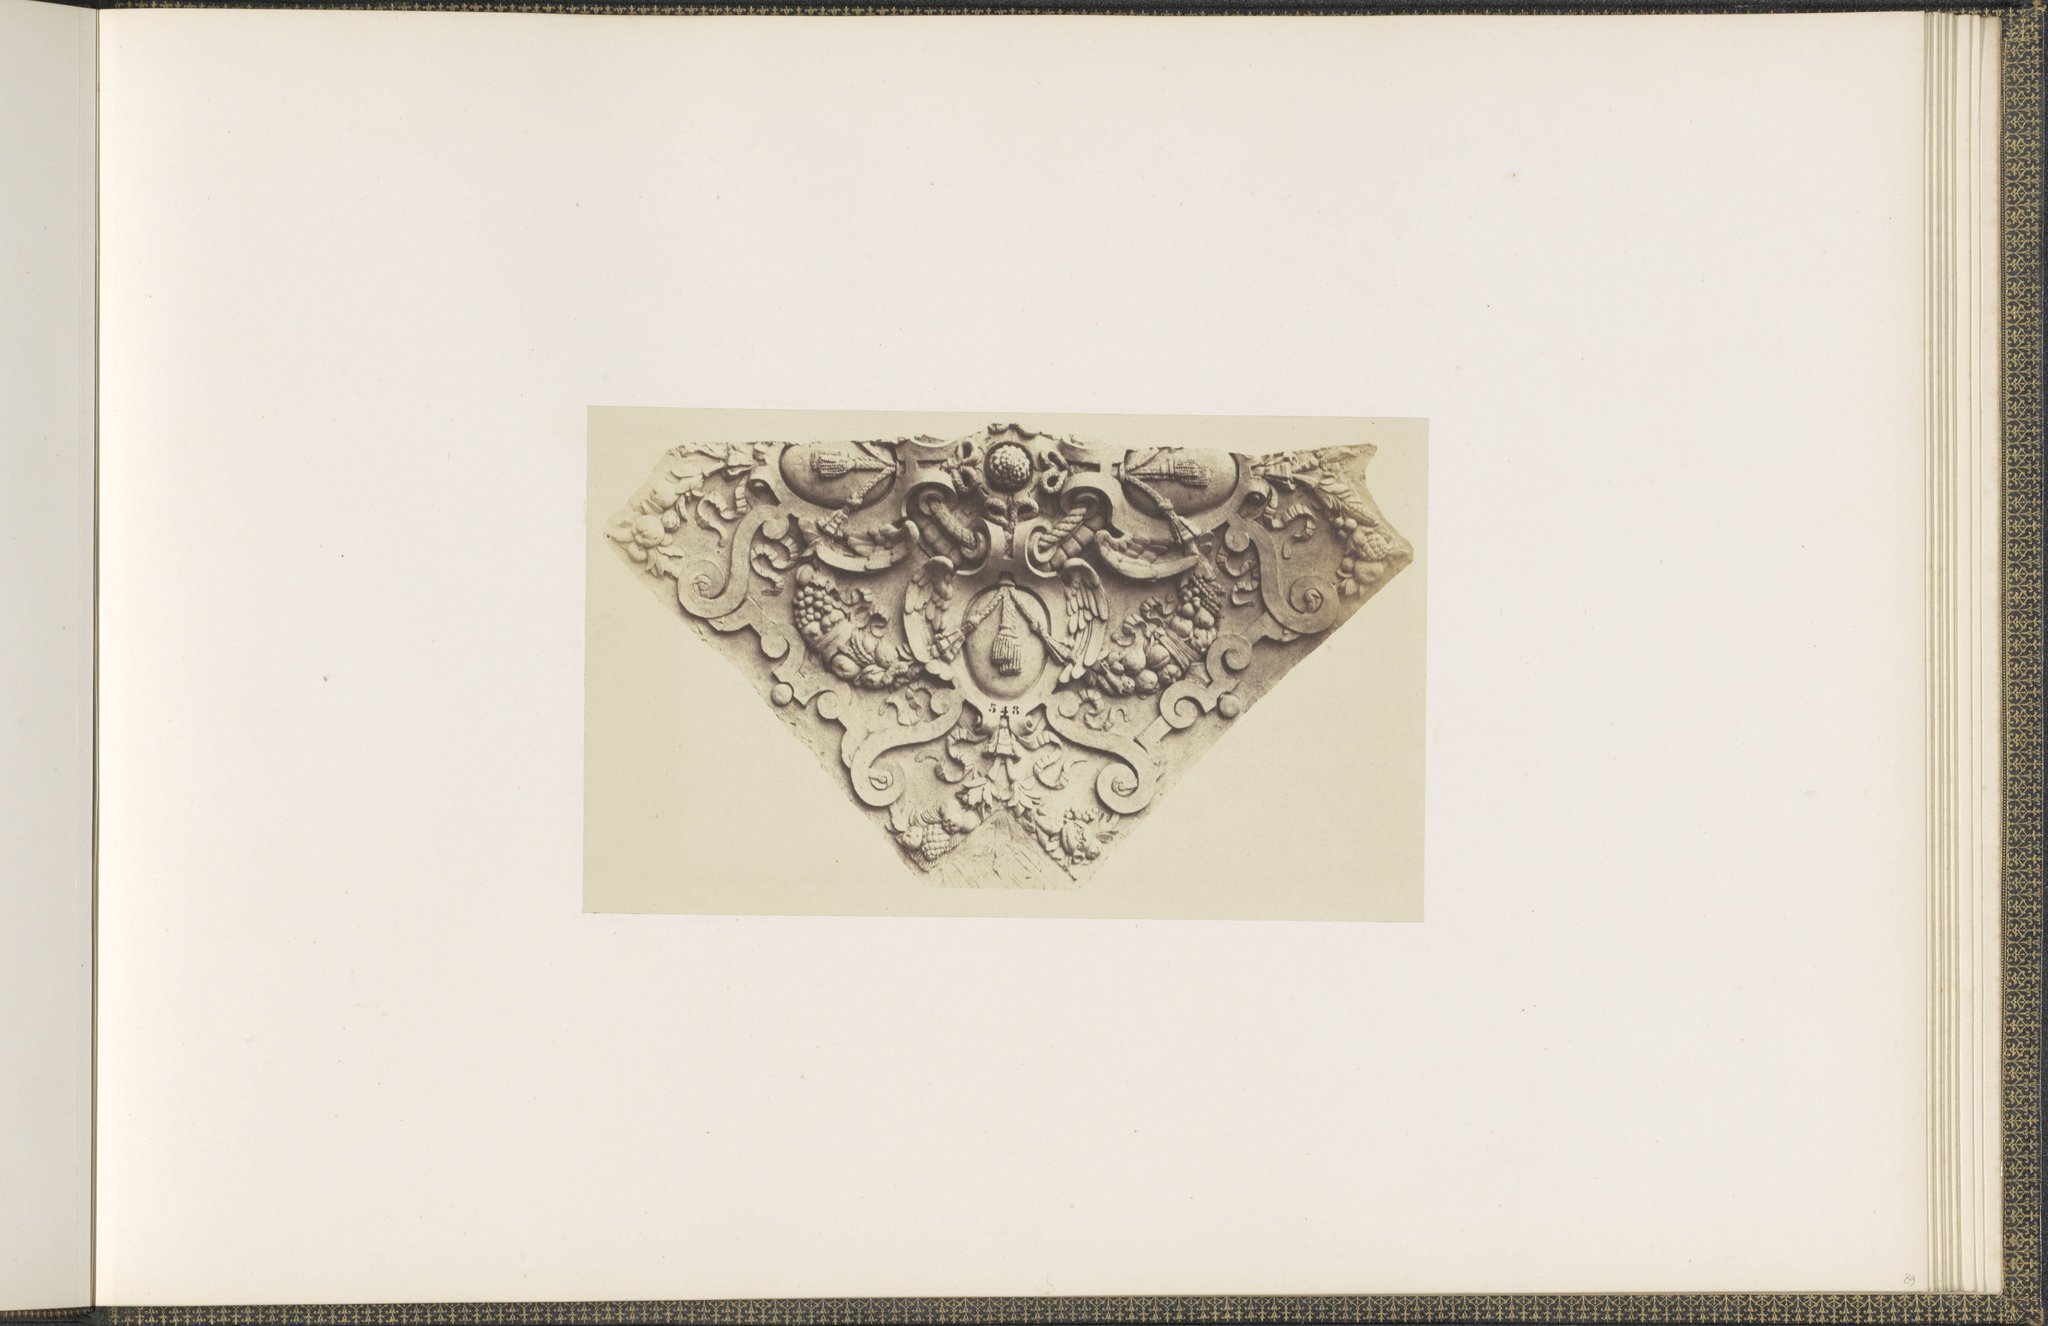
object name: photograph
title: Gipsmodel voor een versiering van het Palais du Louvre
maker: édouard denis baldus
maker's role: fotograaf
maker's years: 1813-1889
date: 1855-1857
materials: paper, photographic support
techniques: salted paper print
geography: paris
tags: permanent exhibition, museum, ornamenting, decorating ~ applied arts, paris, tuileries palace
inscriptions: number: ‘548’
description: Onderdeel van Réunion des Tuileries au Louvre 1852-1857, album 4.